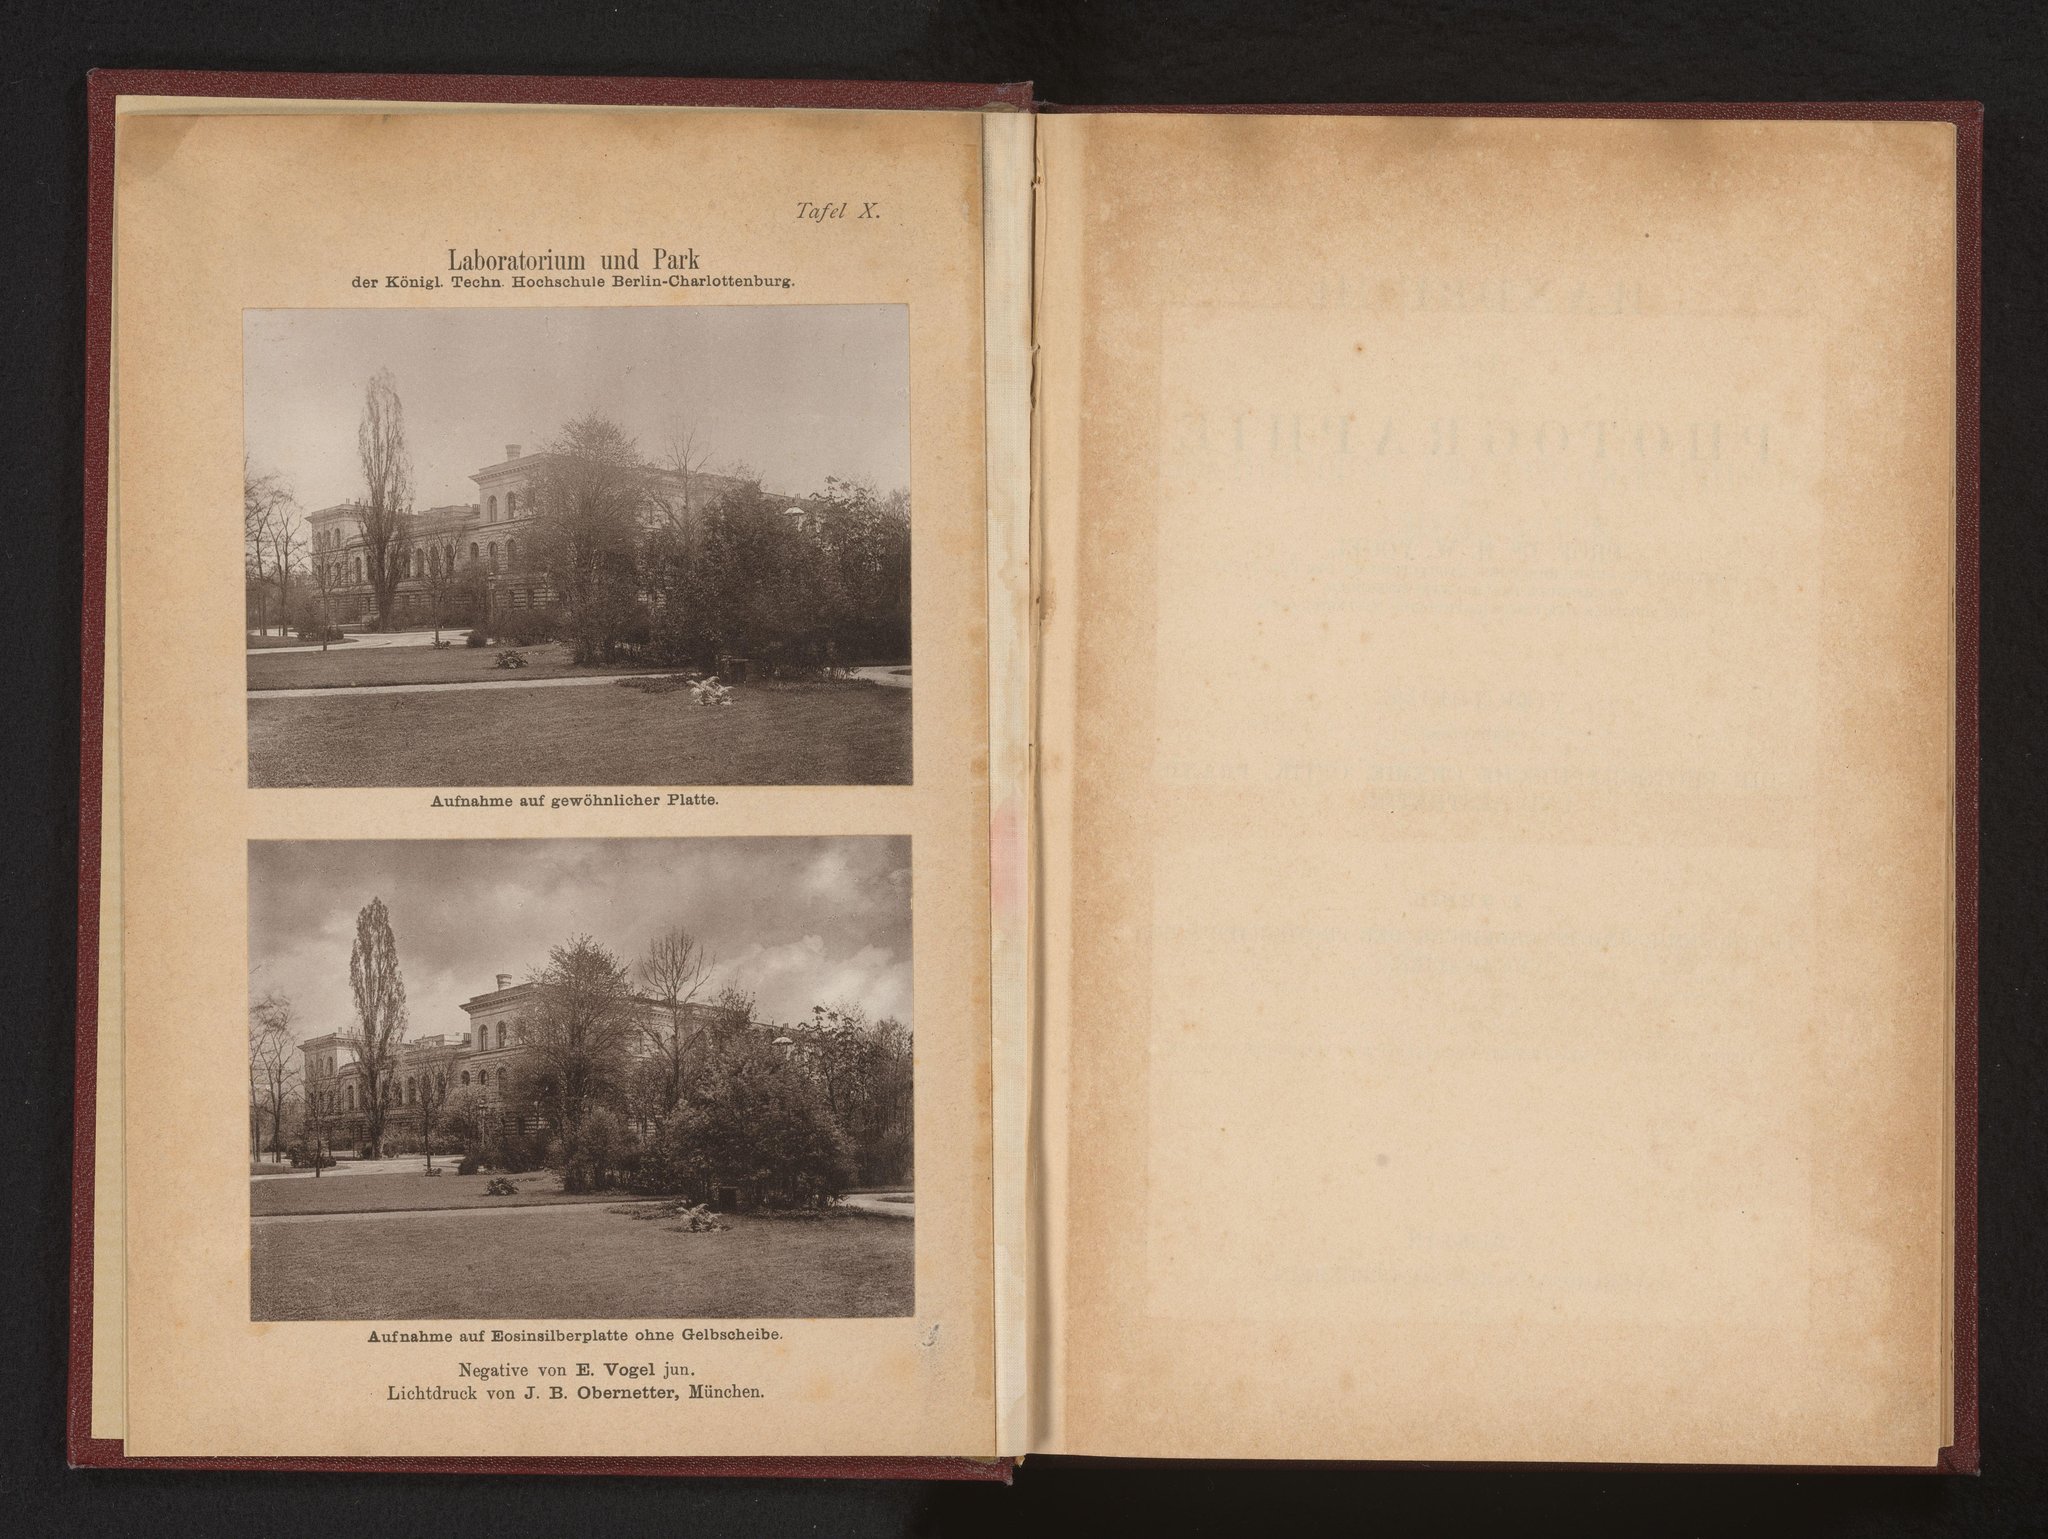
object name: photomechanical print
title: Laboratorium und Park der Königl. Techn. Hochschule Berlin- Charlottenburg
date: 1885-1890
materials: paper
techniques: photograph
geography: munich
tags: exterior ~ representation of a building, university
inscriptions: inscription: ‘Negative von E. Vogel jun./ Lichtdruck von J.B. Obernetter, München.’, inscription: ‘Aufnahme auf Eosinsilberplatte ohne Gelbscheibe.’, number: ‘Tafel X.’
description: Prent op tweede ongenummerde pagina voor titelpagina.